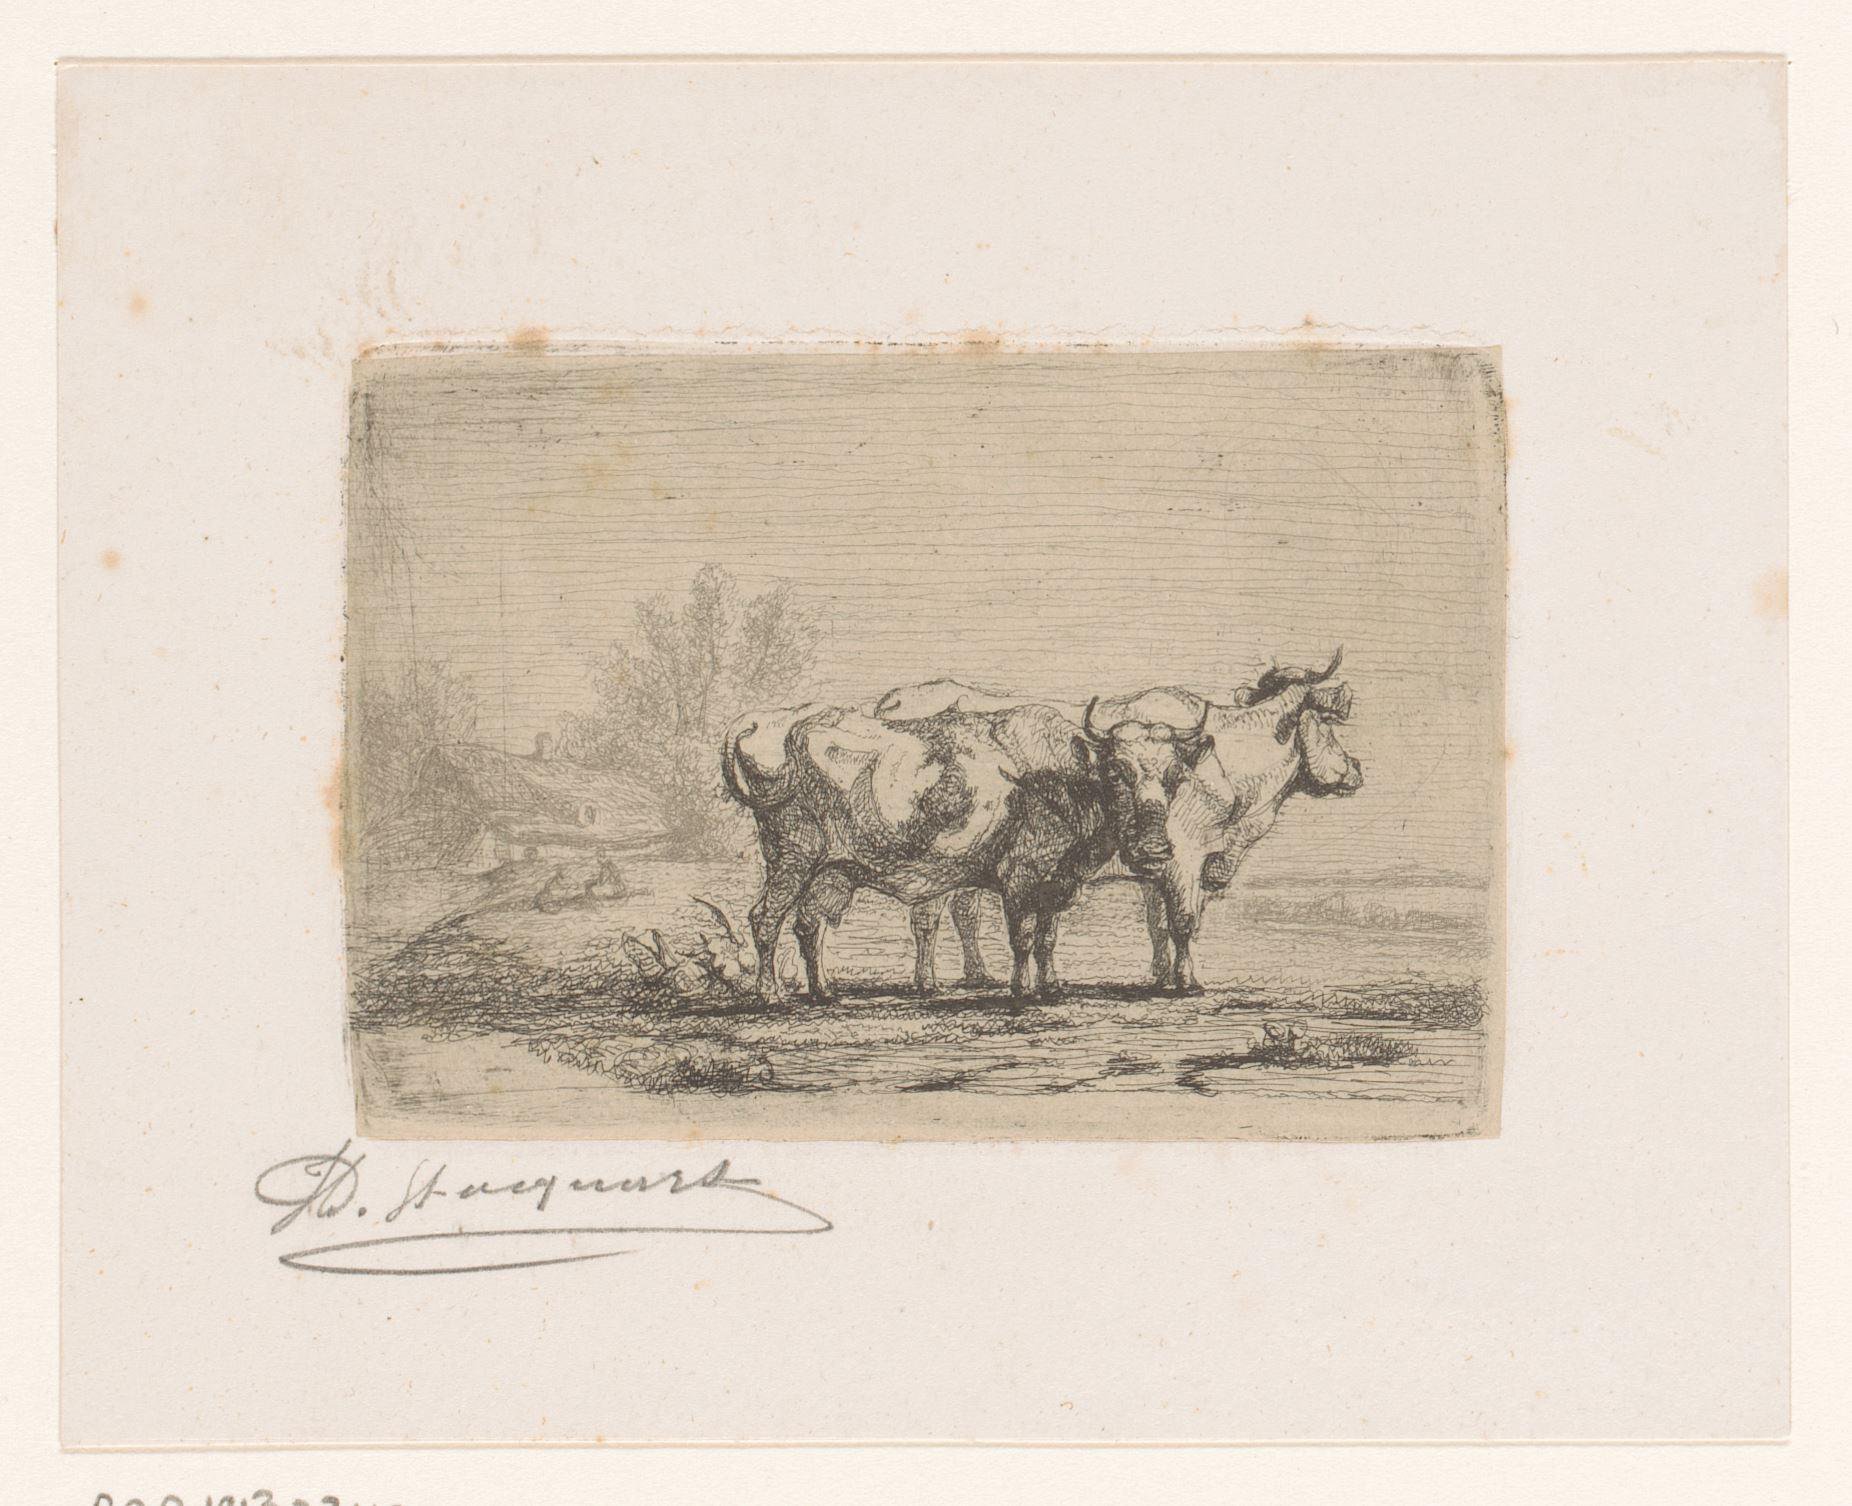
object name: print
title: Landschap met twee koeien en op de achtergrond een boerderij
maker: ildephonse stocquart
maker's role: print maker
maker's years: 1819-1889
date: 1829-1879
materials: paper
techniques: etching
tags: cow, meadow, pasture, farm or solitary house in landscape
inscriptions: collector's mark: Lugt 2228